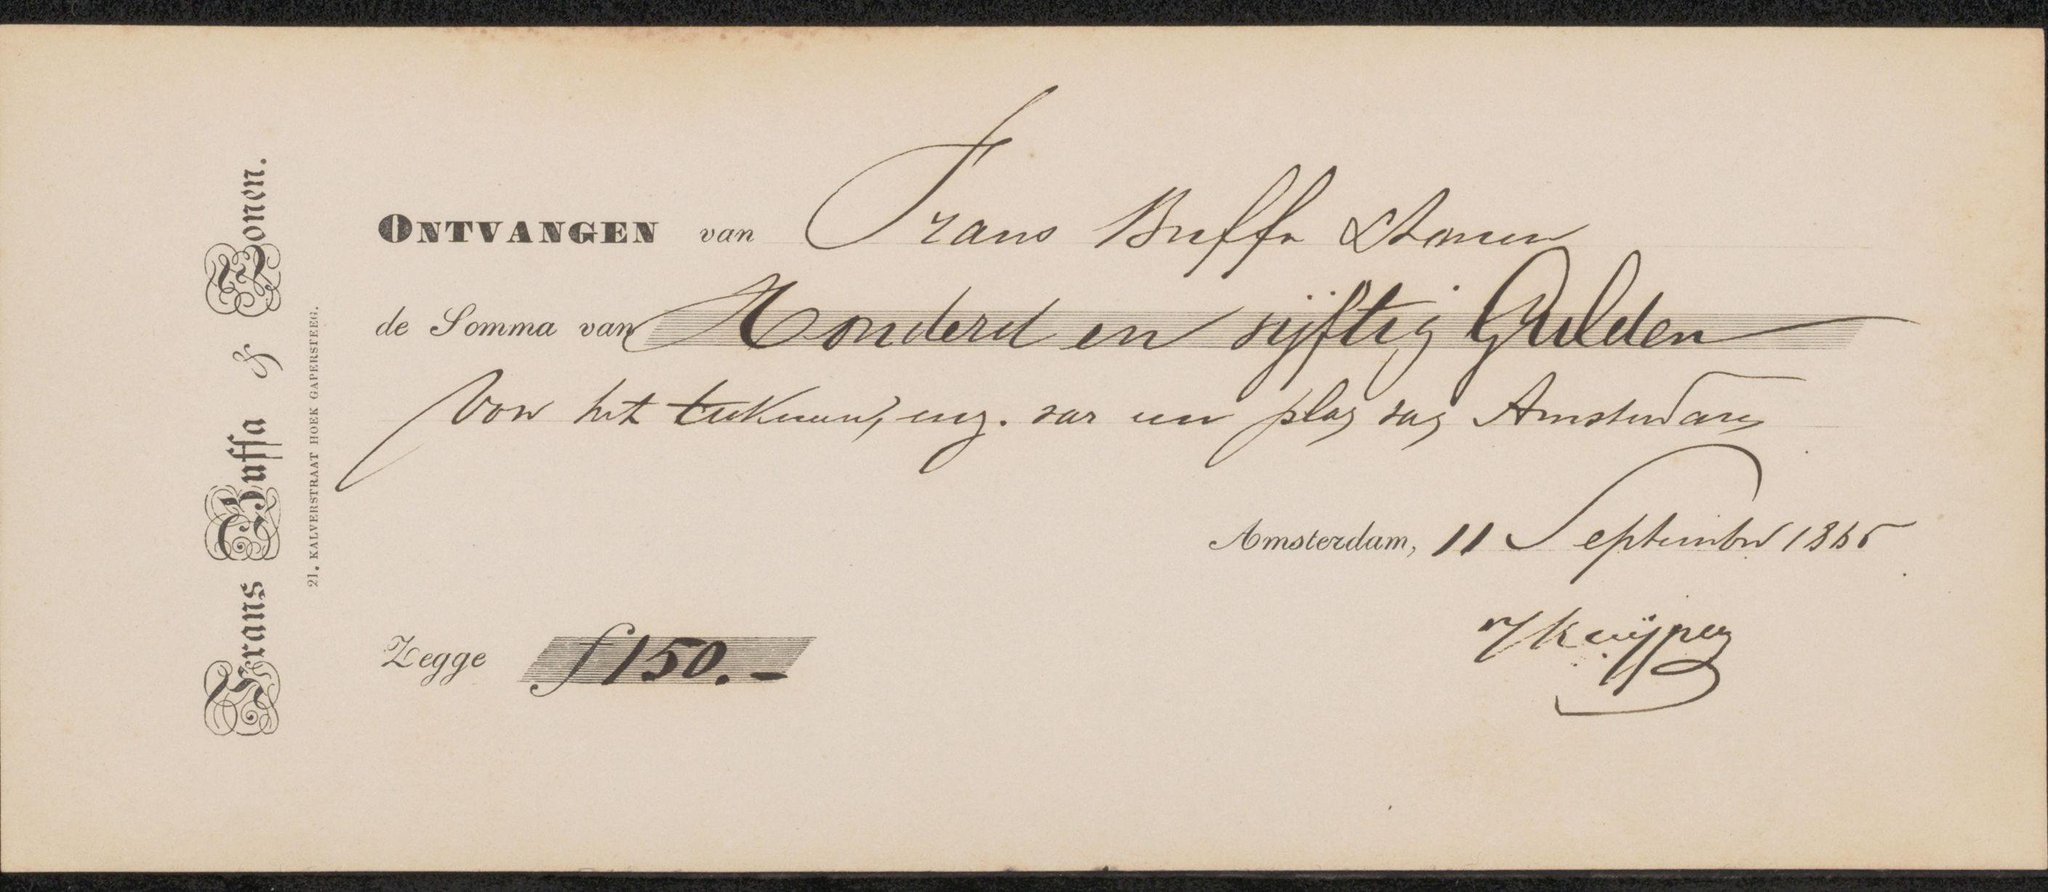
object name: ontvangstbewijs, kwitantie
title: Kwitantie voor Jacob Kuyper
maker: jacob kuyper (1821-1908)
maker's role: cartograaf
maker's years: 1821-1908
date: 1865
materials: ink, paper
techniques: pen, printing, writing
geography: amsterdam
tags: drawing, money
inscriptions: collector's mark: Lugt 2233